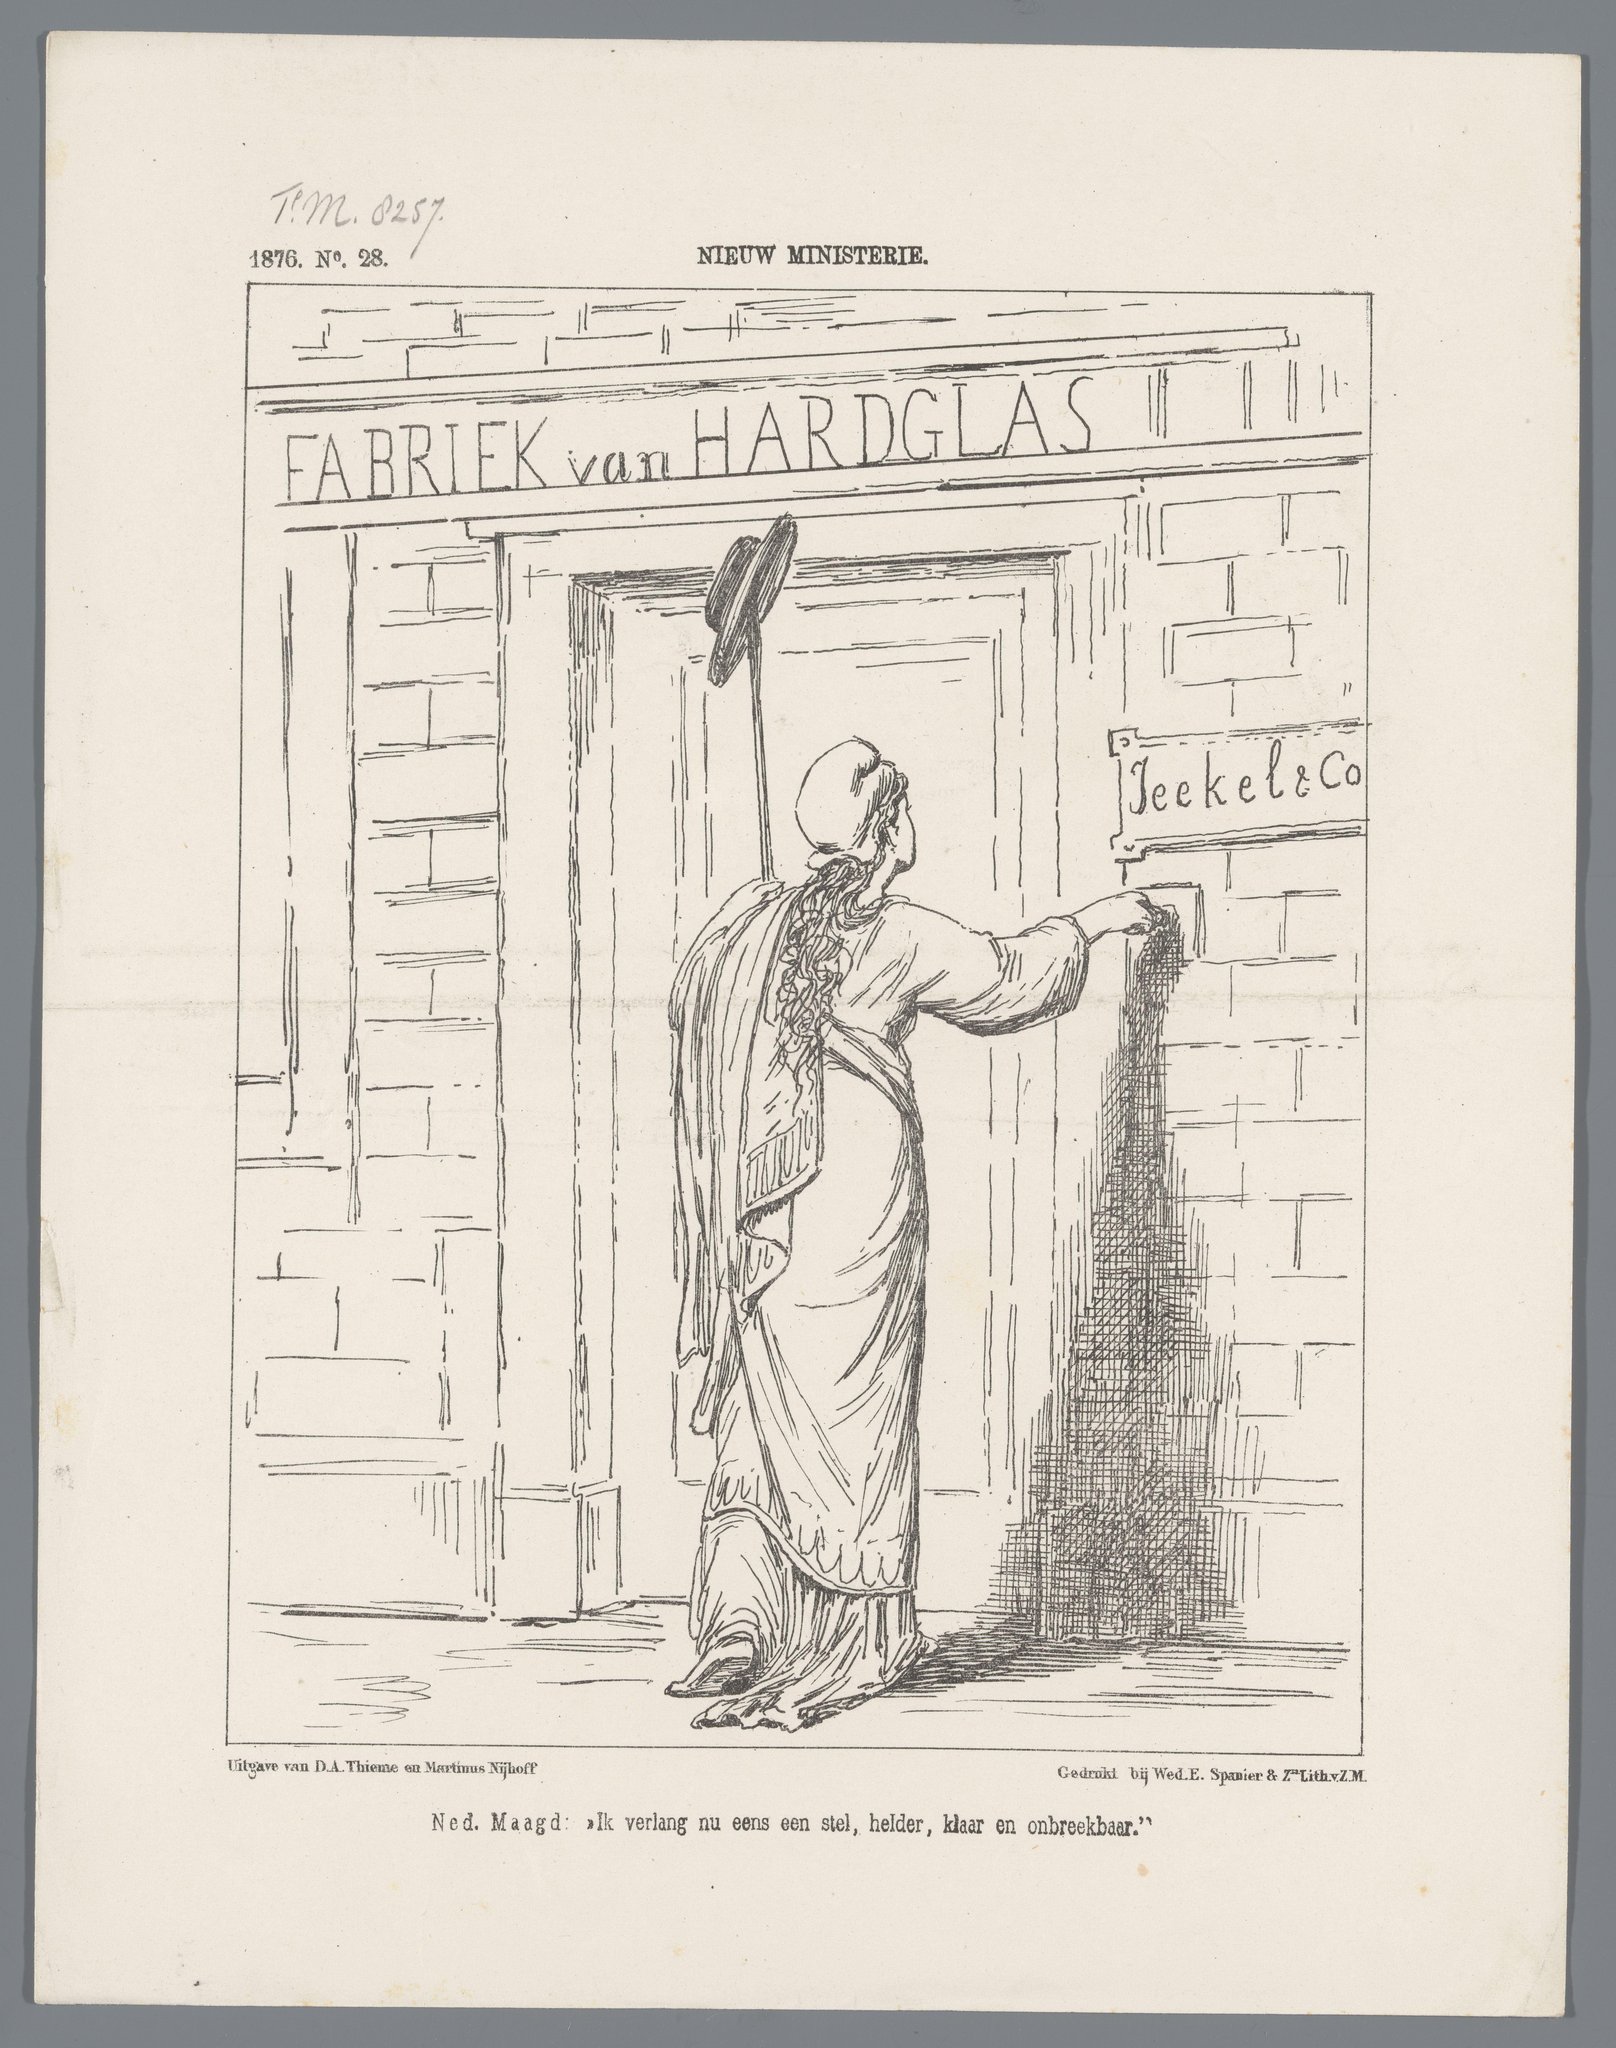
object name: print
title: Blad met twaalf rarekiekplaatjes, 1855-1865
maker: Anonymous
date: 1864-1865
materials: paper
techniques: lithograph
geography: netherlands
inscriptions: collector's mark: Lugt 2228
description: Blad met twaalf plaatjes in de vorm van rarekiekplaatjes met komische voorstellingen van nationale en internationale gebeurtenissen, 1855-1865. Zie ook het tweede blad.